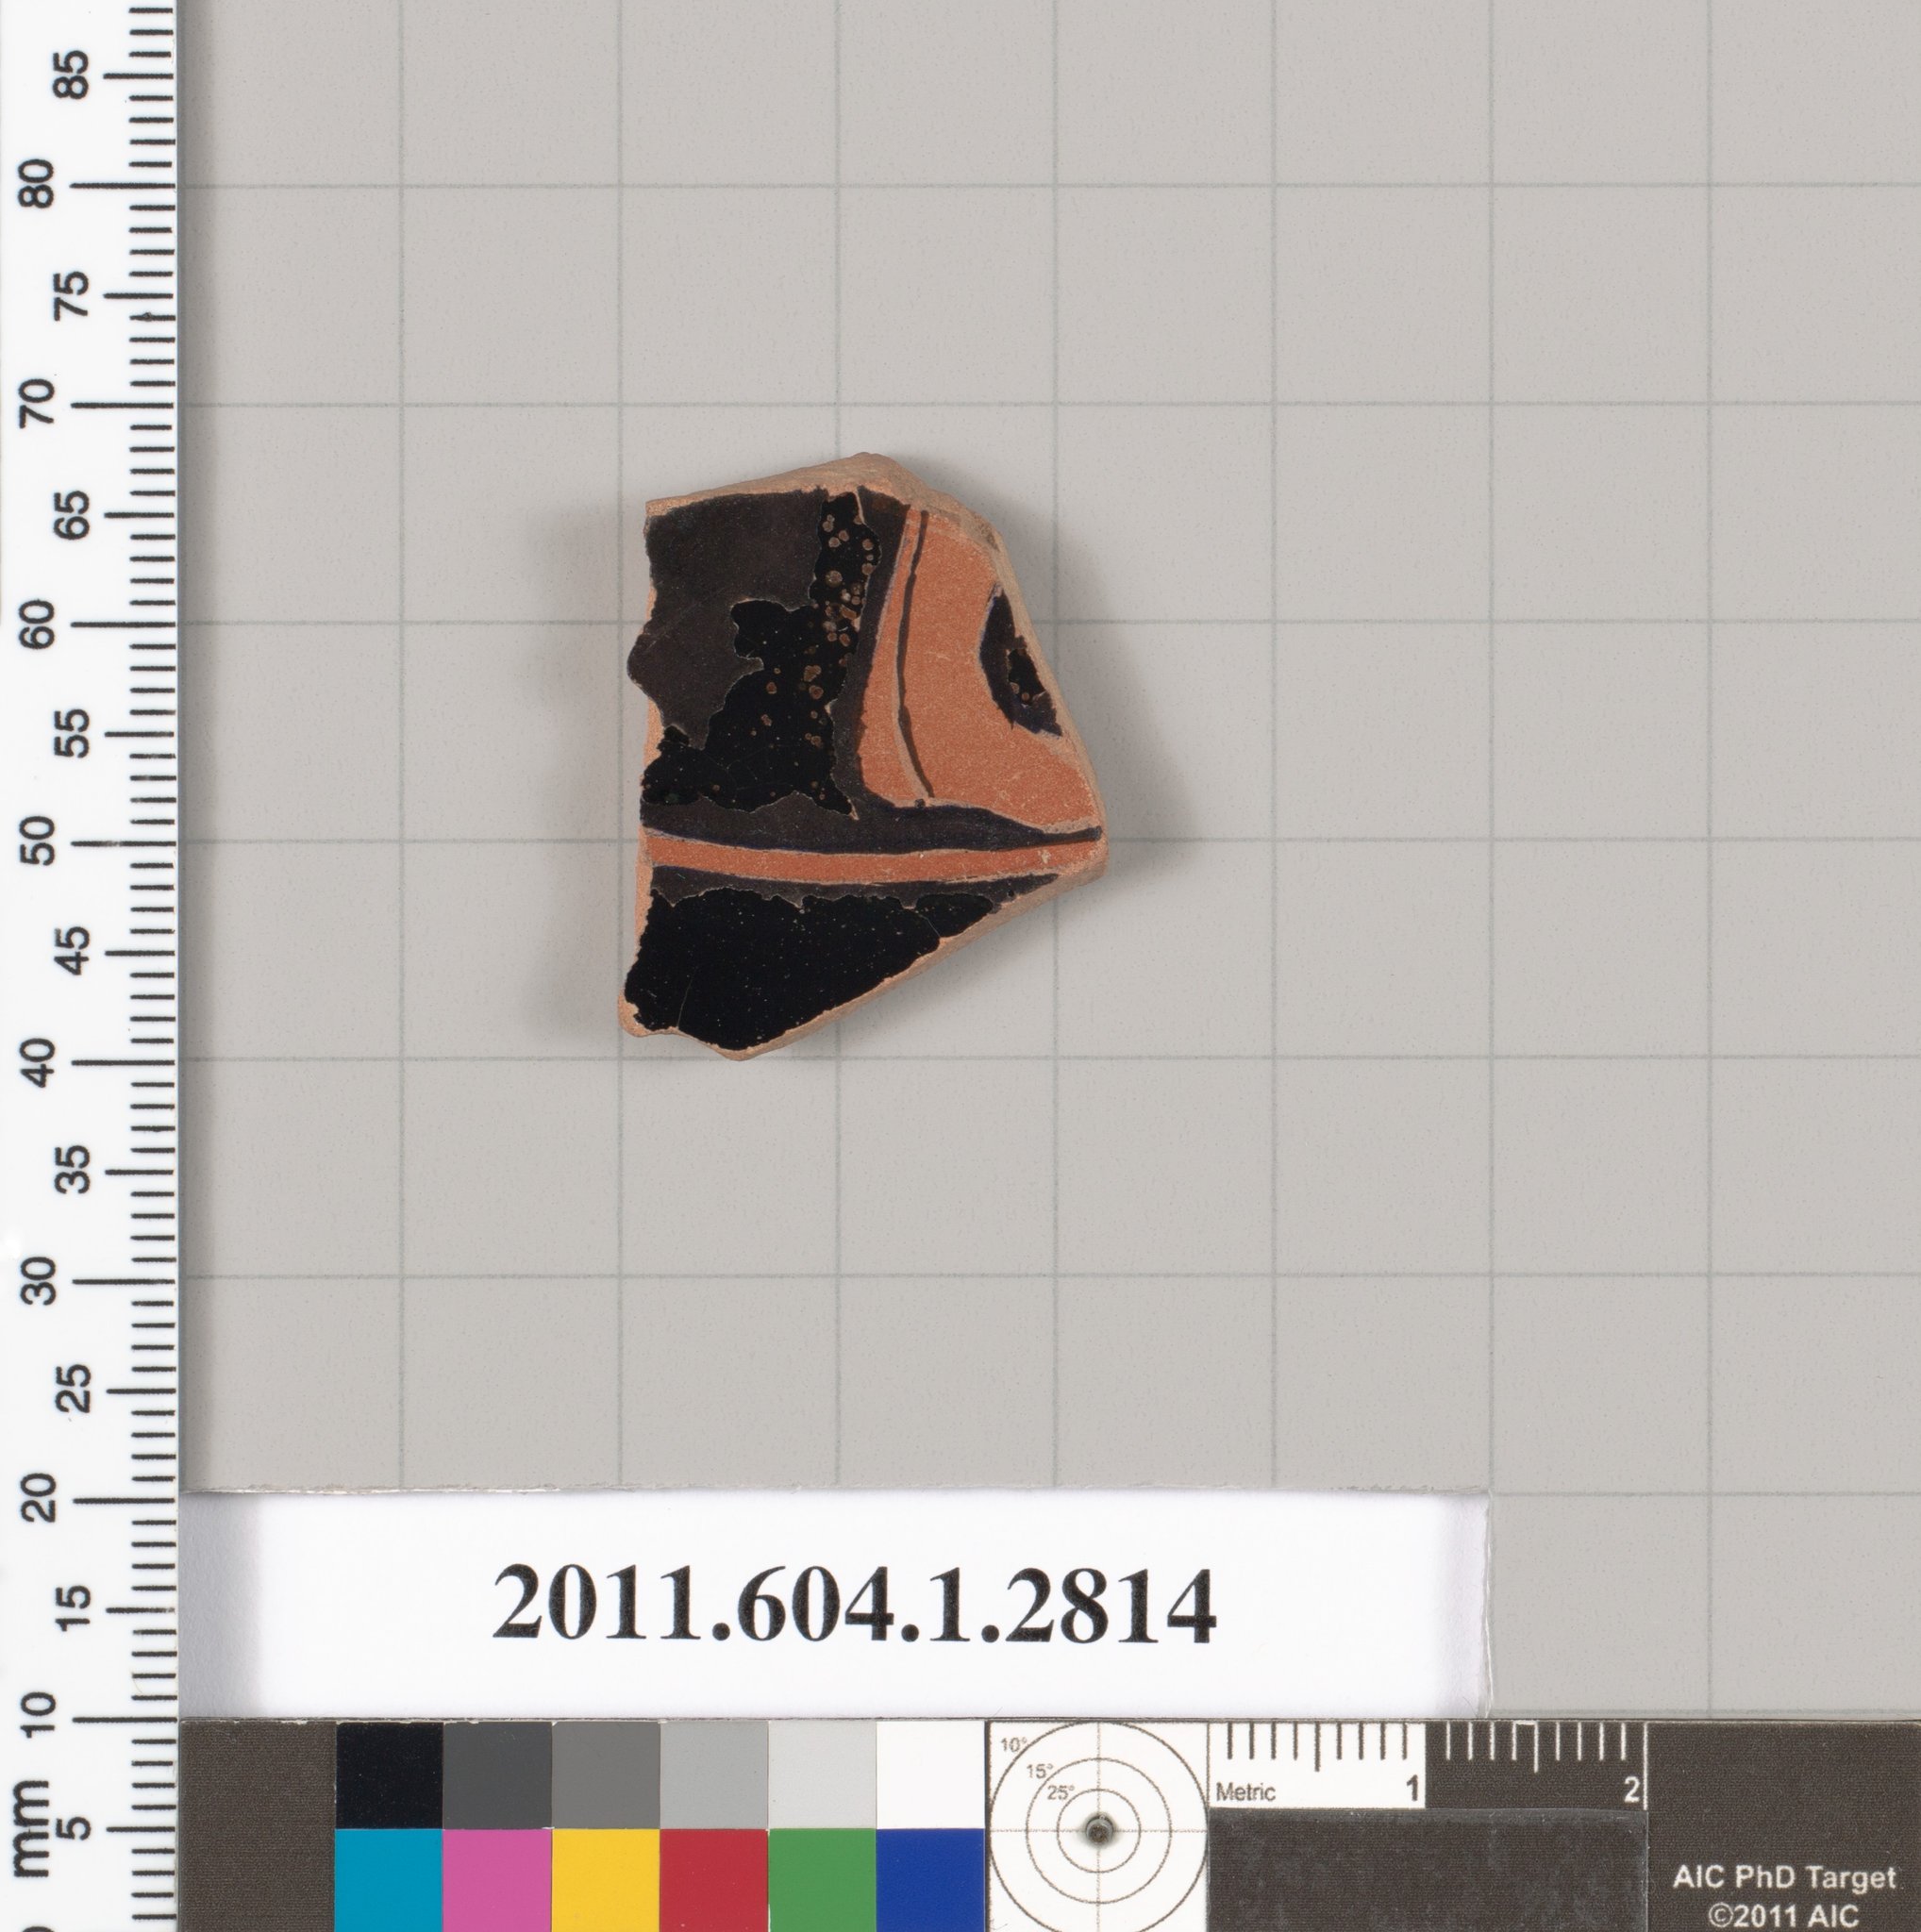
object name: kylix fragment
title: Terracotta fragment of a kylix (drinking cup)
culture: greek, attic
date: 520-500 BCE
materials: terracotta